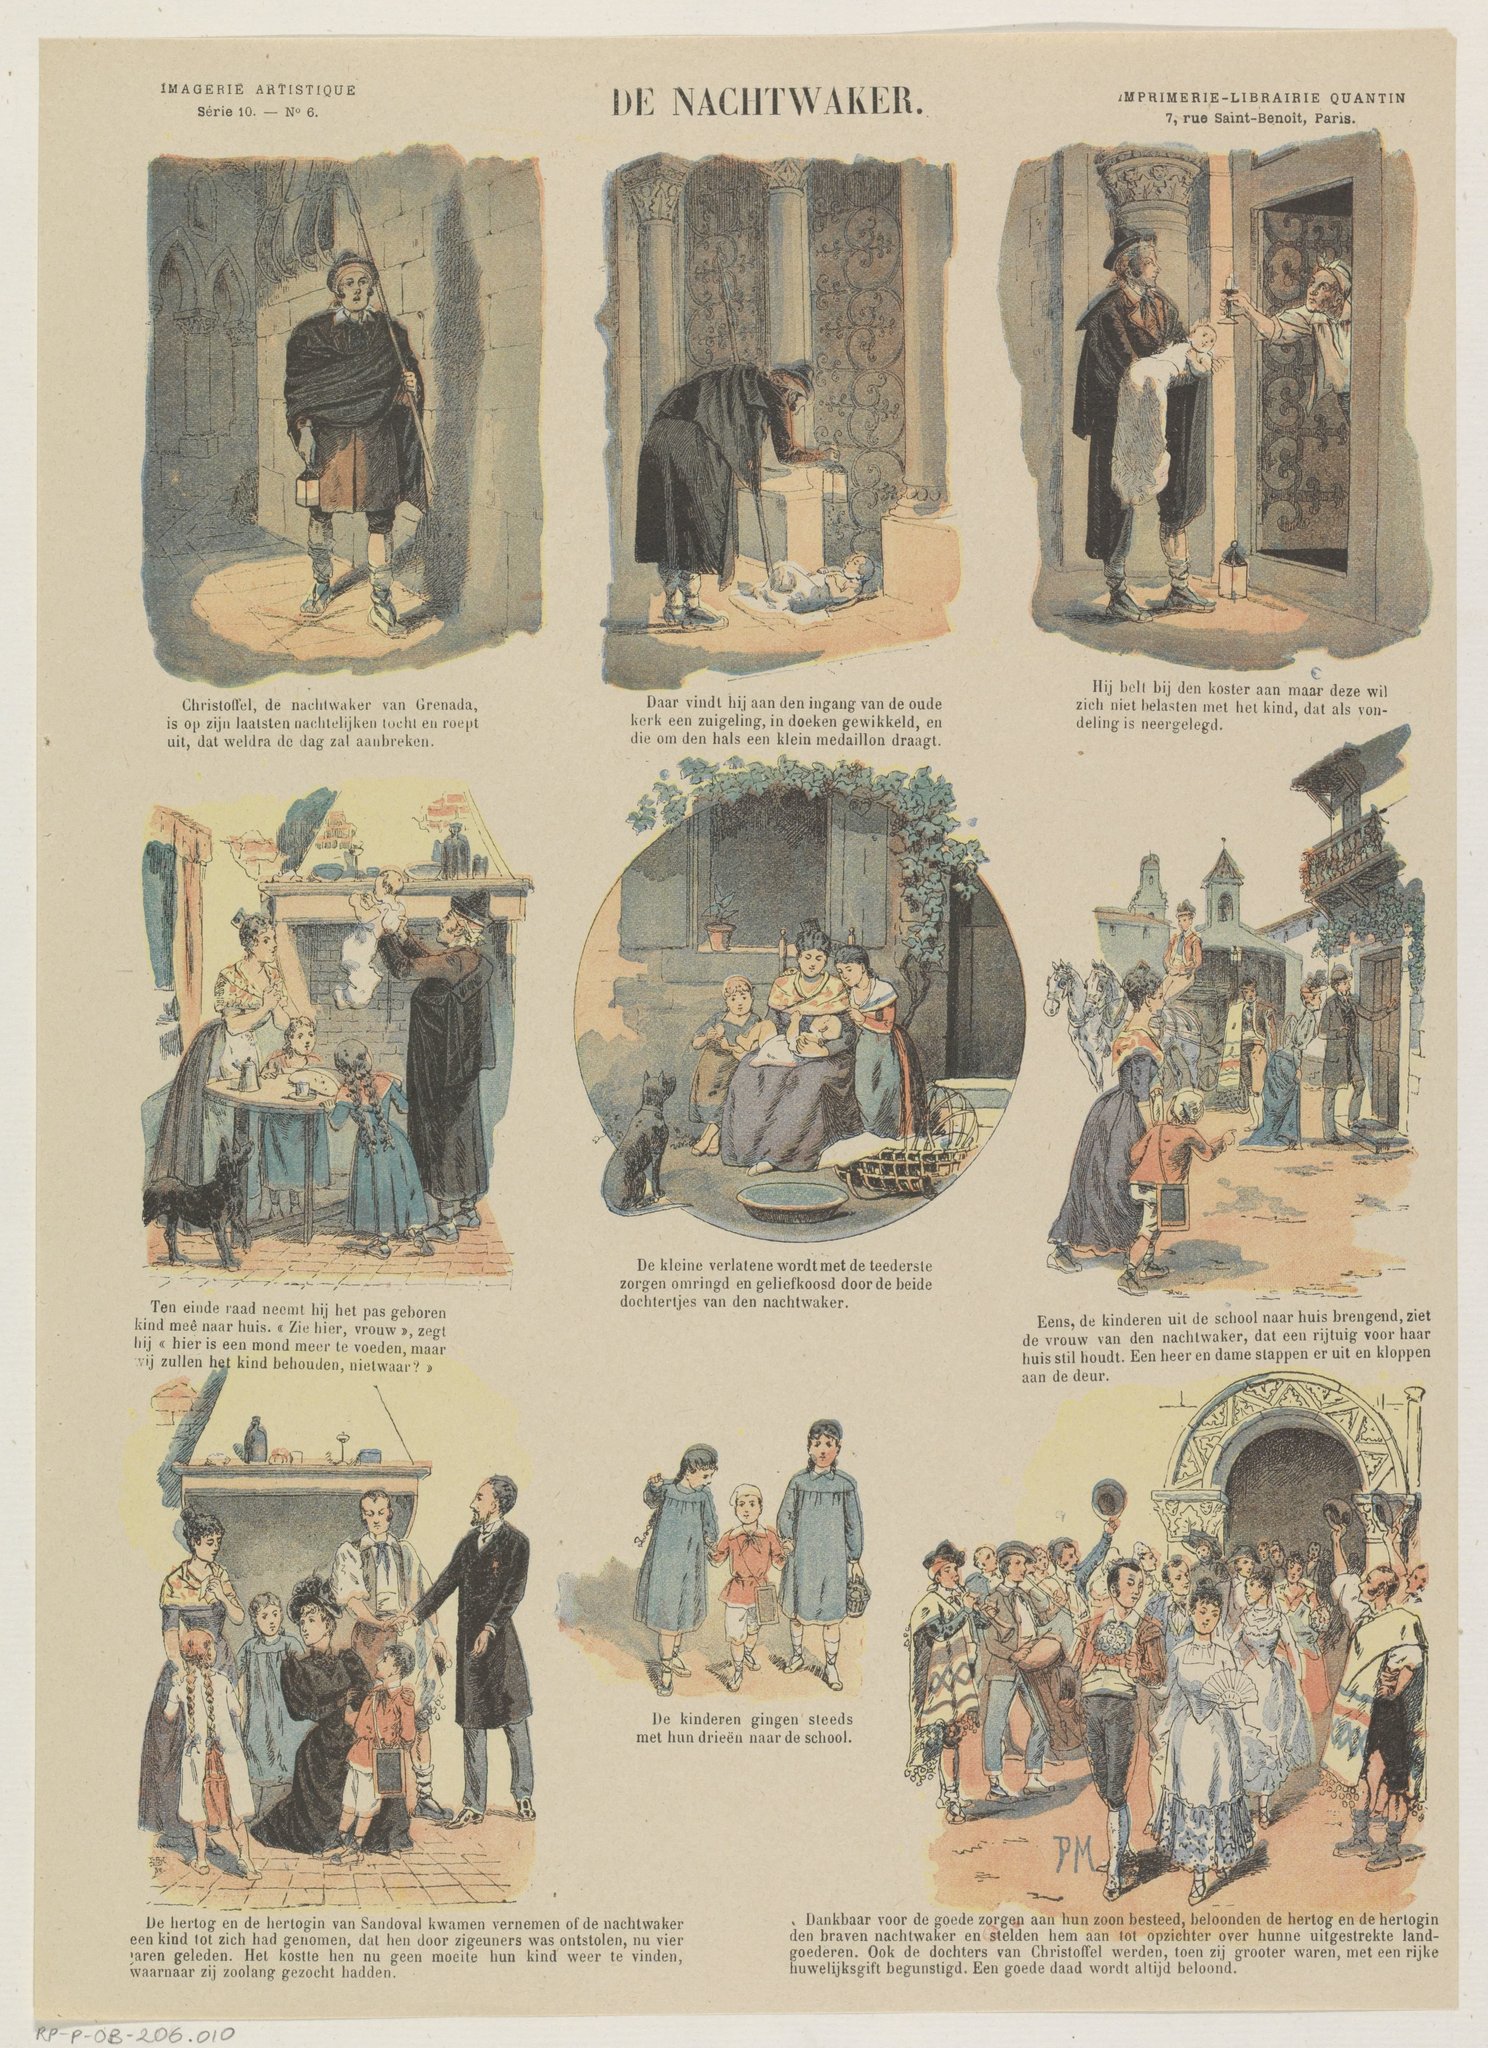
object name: print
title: De nachtwaker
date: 1876-1890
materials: paper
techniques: lithograph, letterpress printing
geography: paris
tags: adoption (of a child), parts of hacking and thrusting weapons: guard, foundling (and adoption), tales and fairy tales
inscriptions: collector's mark: Lugt 2760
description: Blad met 9 voorstellingen van een nachtwaker die een gevonden kind in huis neemt. Vier jaar later blijkt het kind gestolen te zijn van een rijke heer en dame. De nachtwaker wordt rijkelijk beloond voor zijn goede zorgen. Onder elke afbeelding een onderschrift. Genummerd linksboven: Série 10. - No. 6.